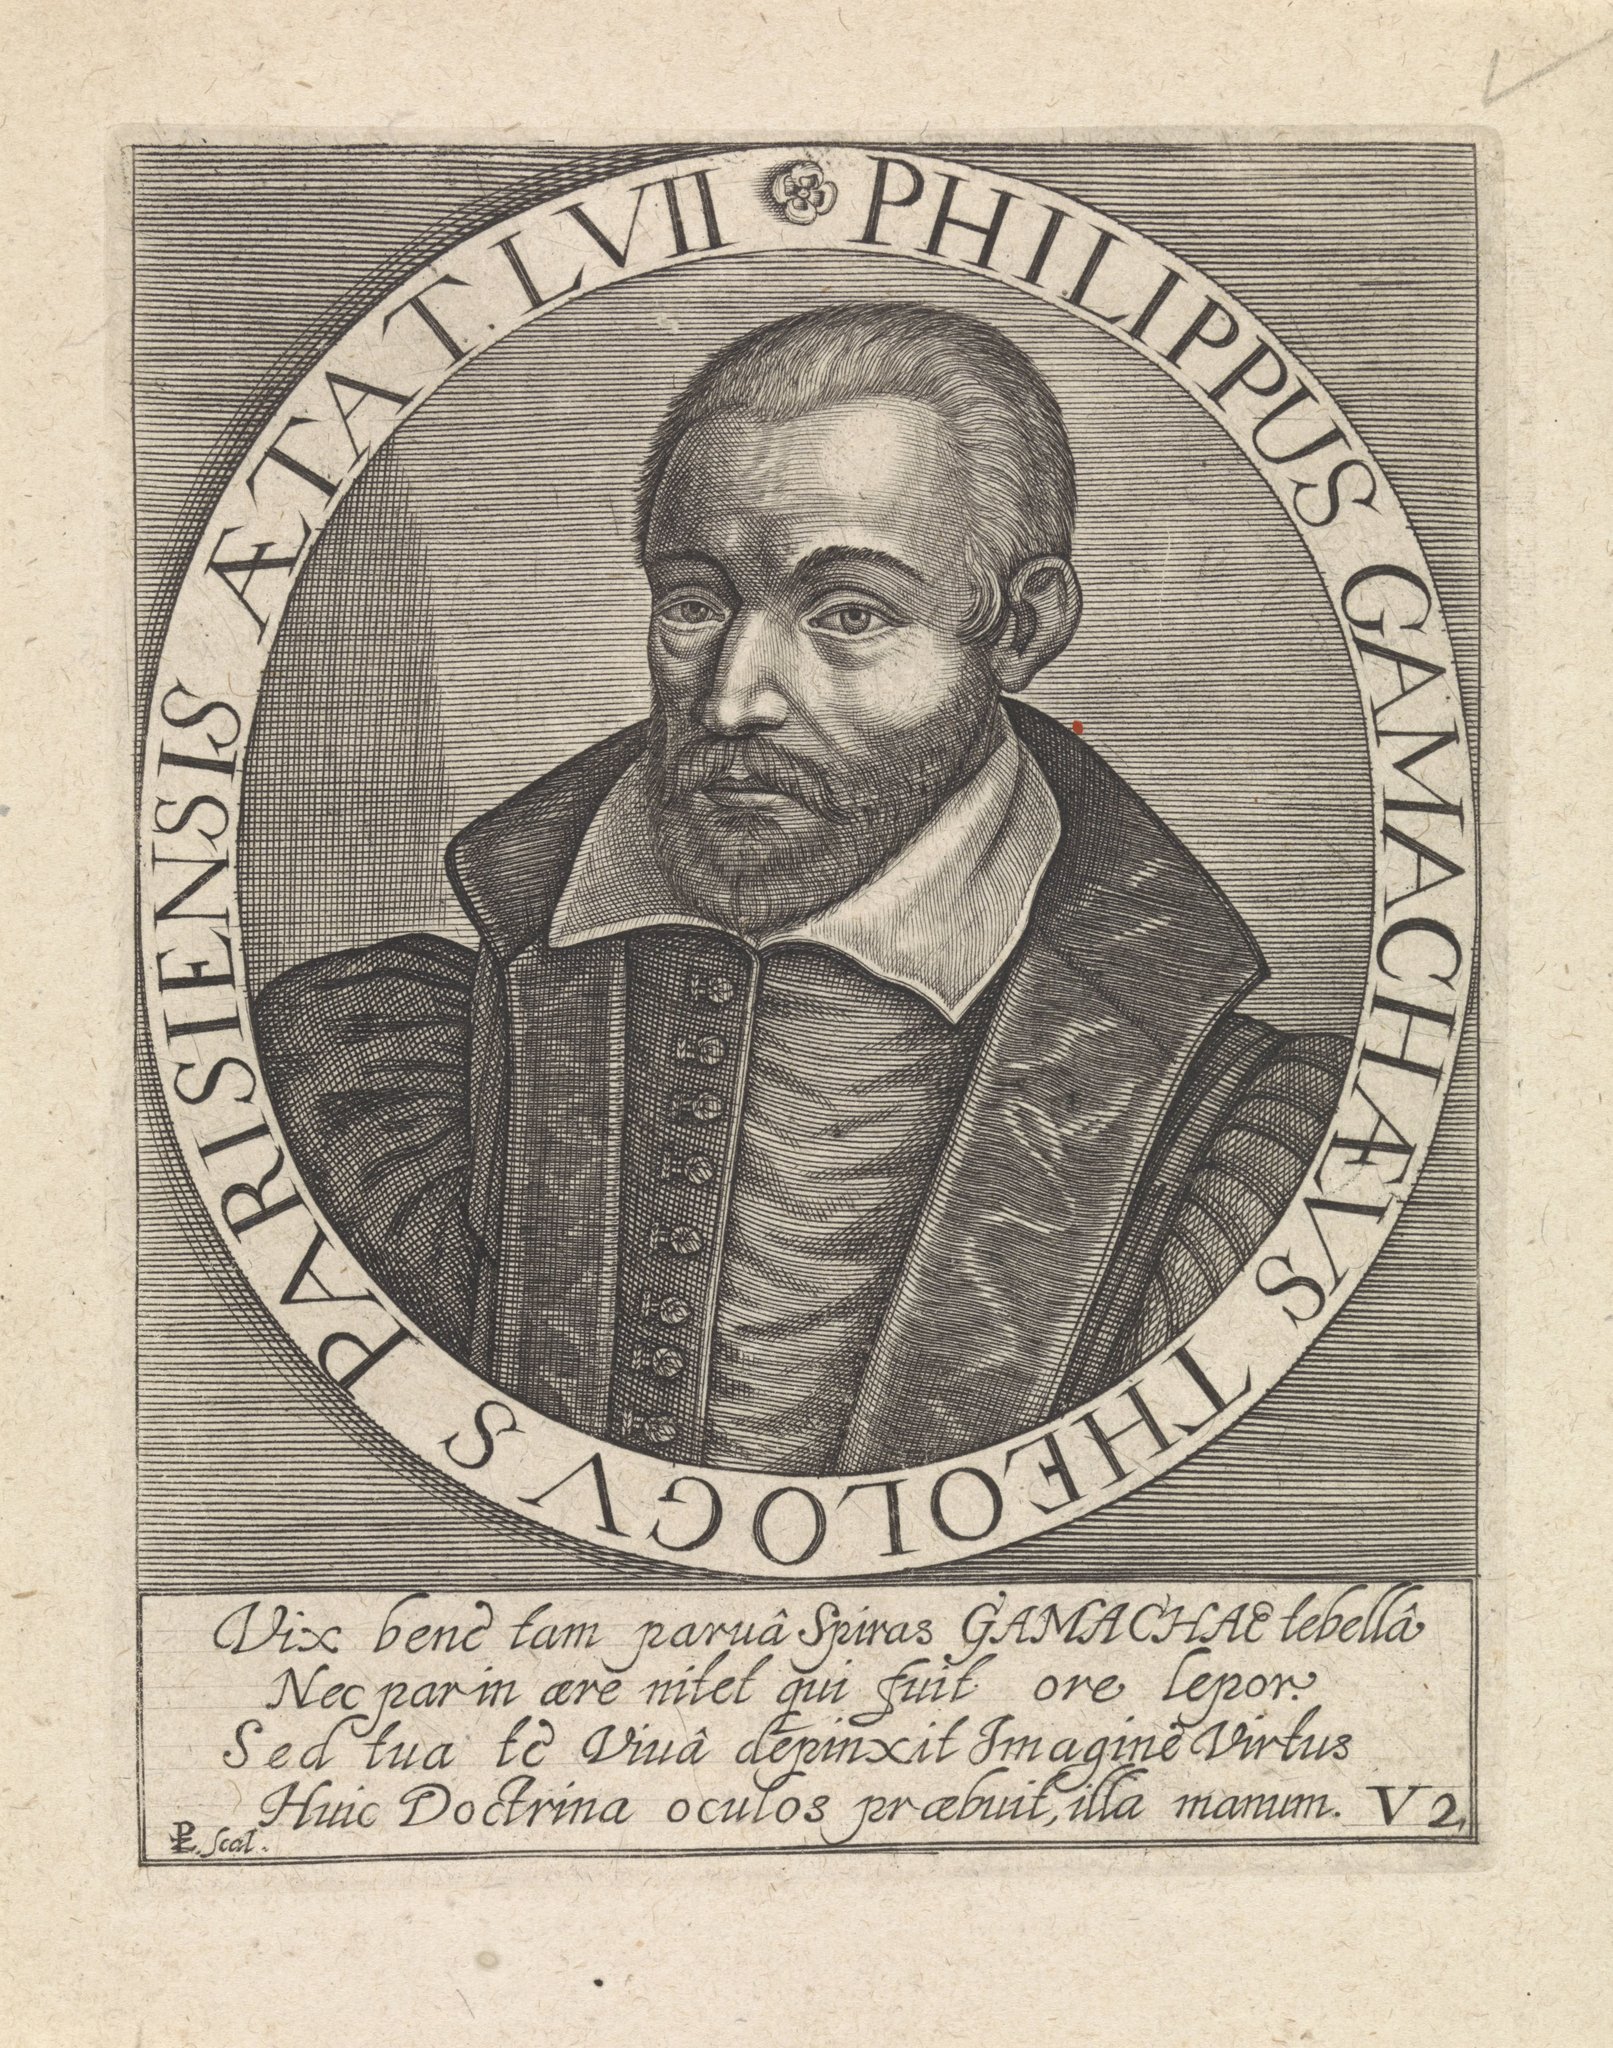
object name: print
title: Portretten van beroemde Europese wetenschappers, humanisten en geestelijken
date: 1650-1669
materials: paper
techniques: engraving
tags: paris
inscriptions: collector's mark: Lugt 2228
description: Prent gebruikt in een van de edities van Jean-Jacques Boissard. Boissard, Jean-Jacques. Bibliotheca sive Thesaurus Virtutis et Gloriae: In quo continentus Illvstrivm Ervditione & doctrina Virorum Effigies & Vitae (...). Frankfurt, [1628]. Zie Hollstein Dutch, deel LVIII, p. 86-87.